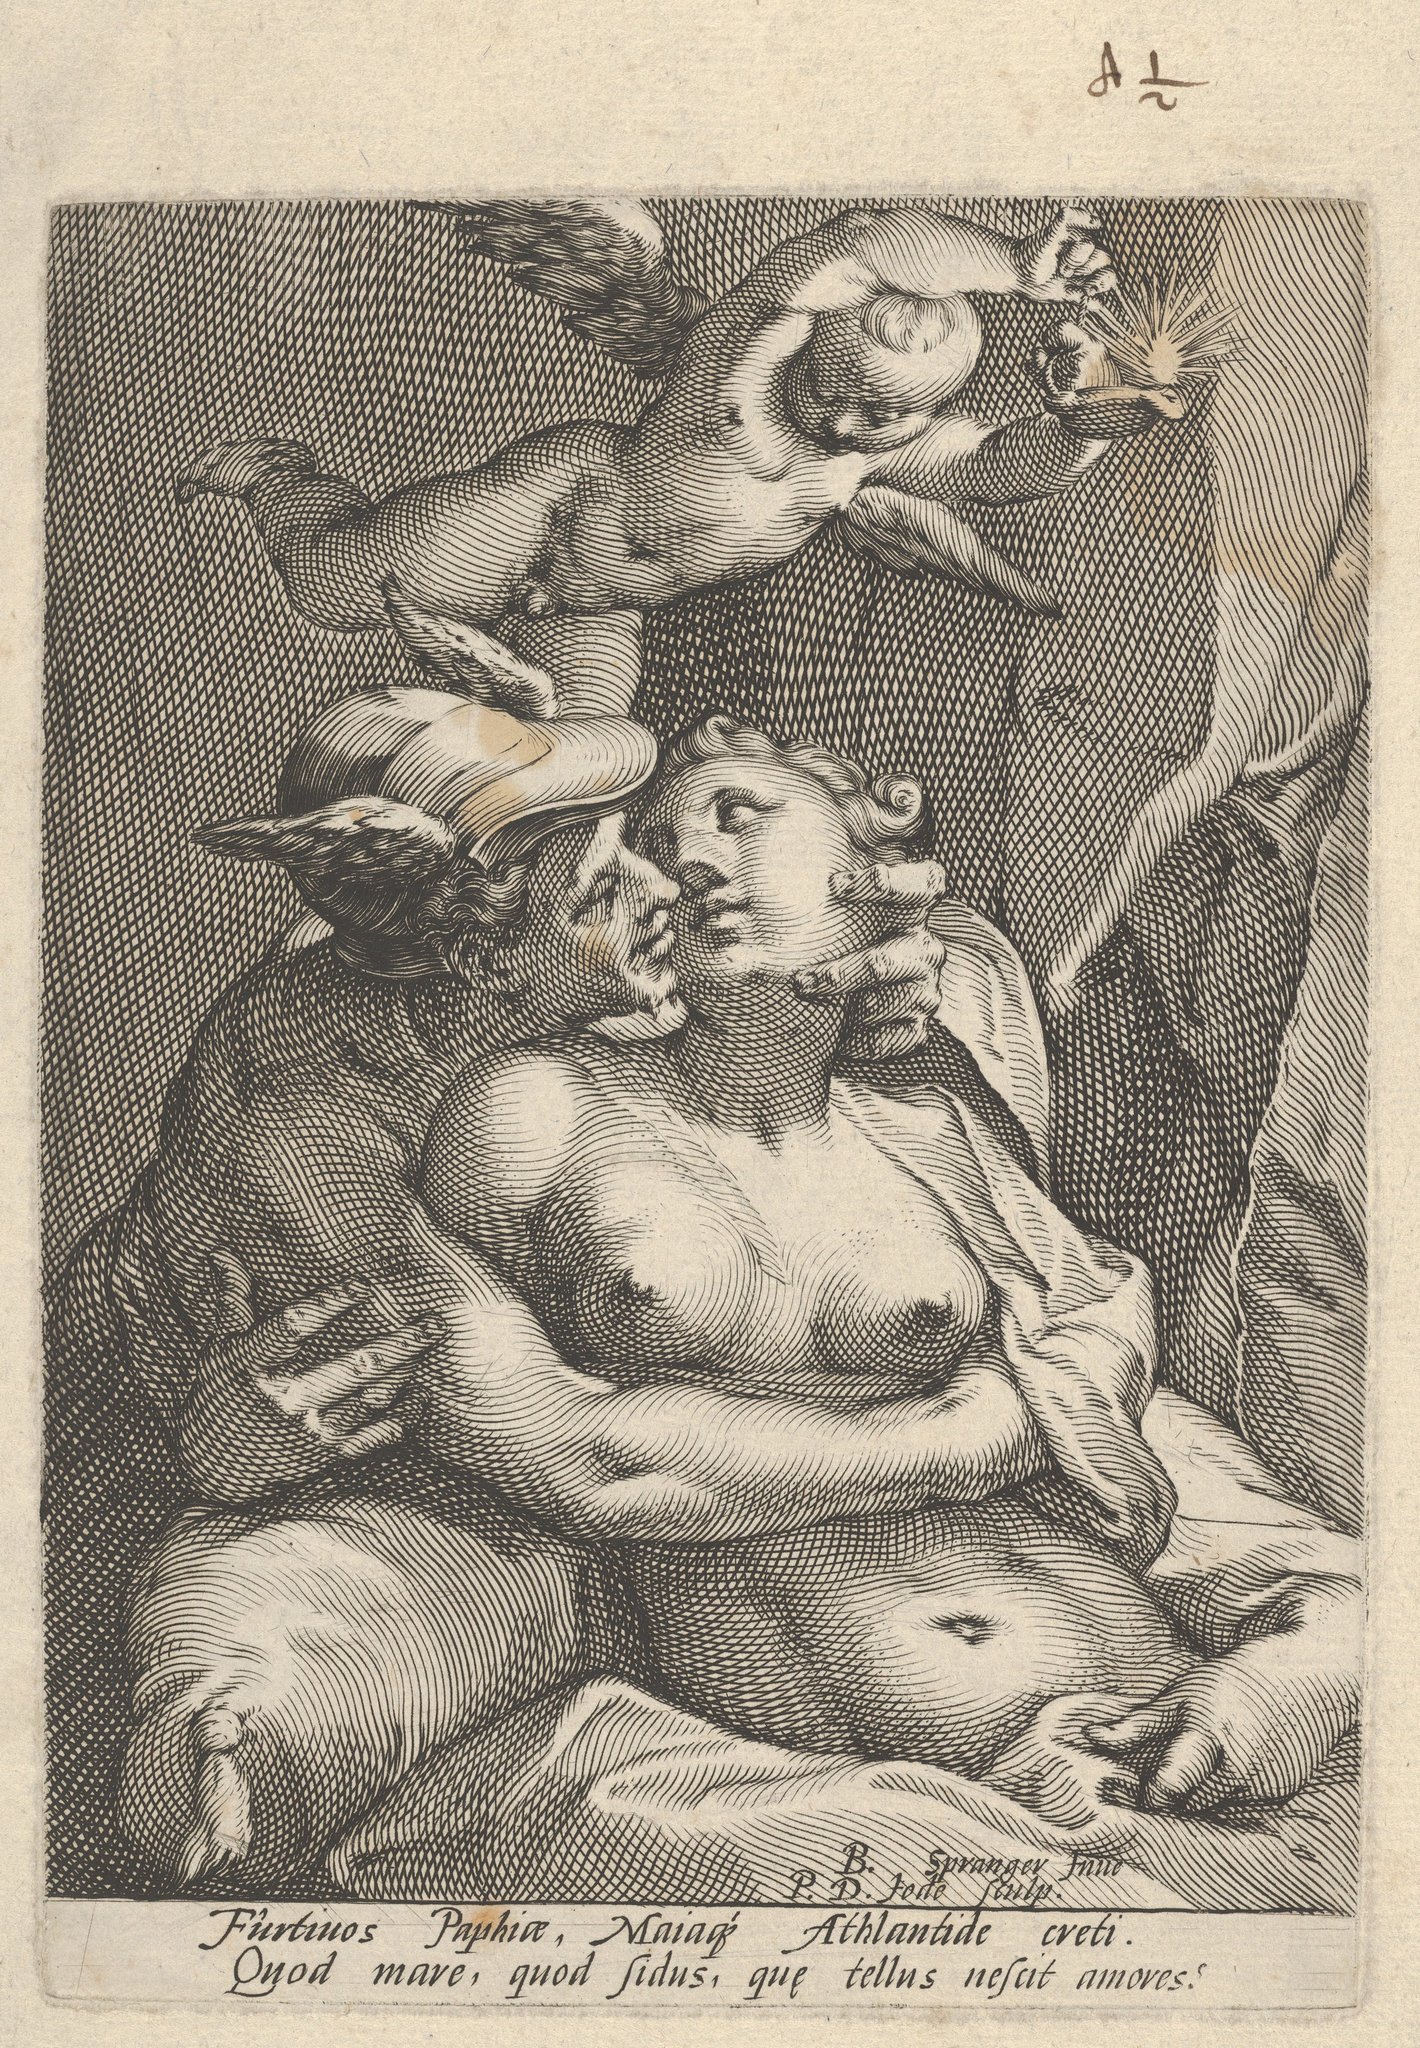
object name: print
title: Mercury Embracing Venus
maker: pieter de jode (i)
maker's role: artist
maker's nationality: netherlandish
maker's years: 1570-1634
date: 1588-1634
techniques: engraving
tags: mercury,venus